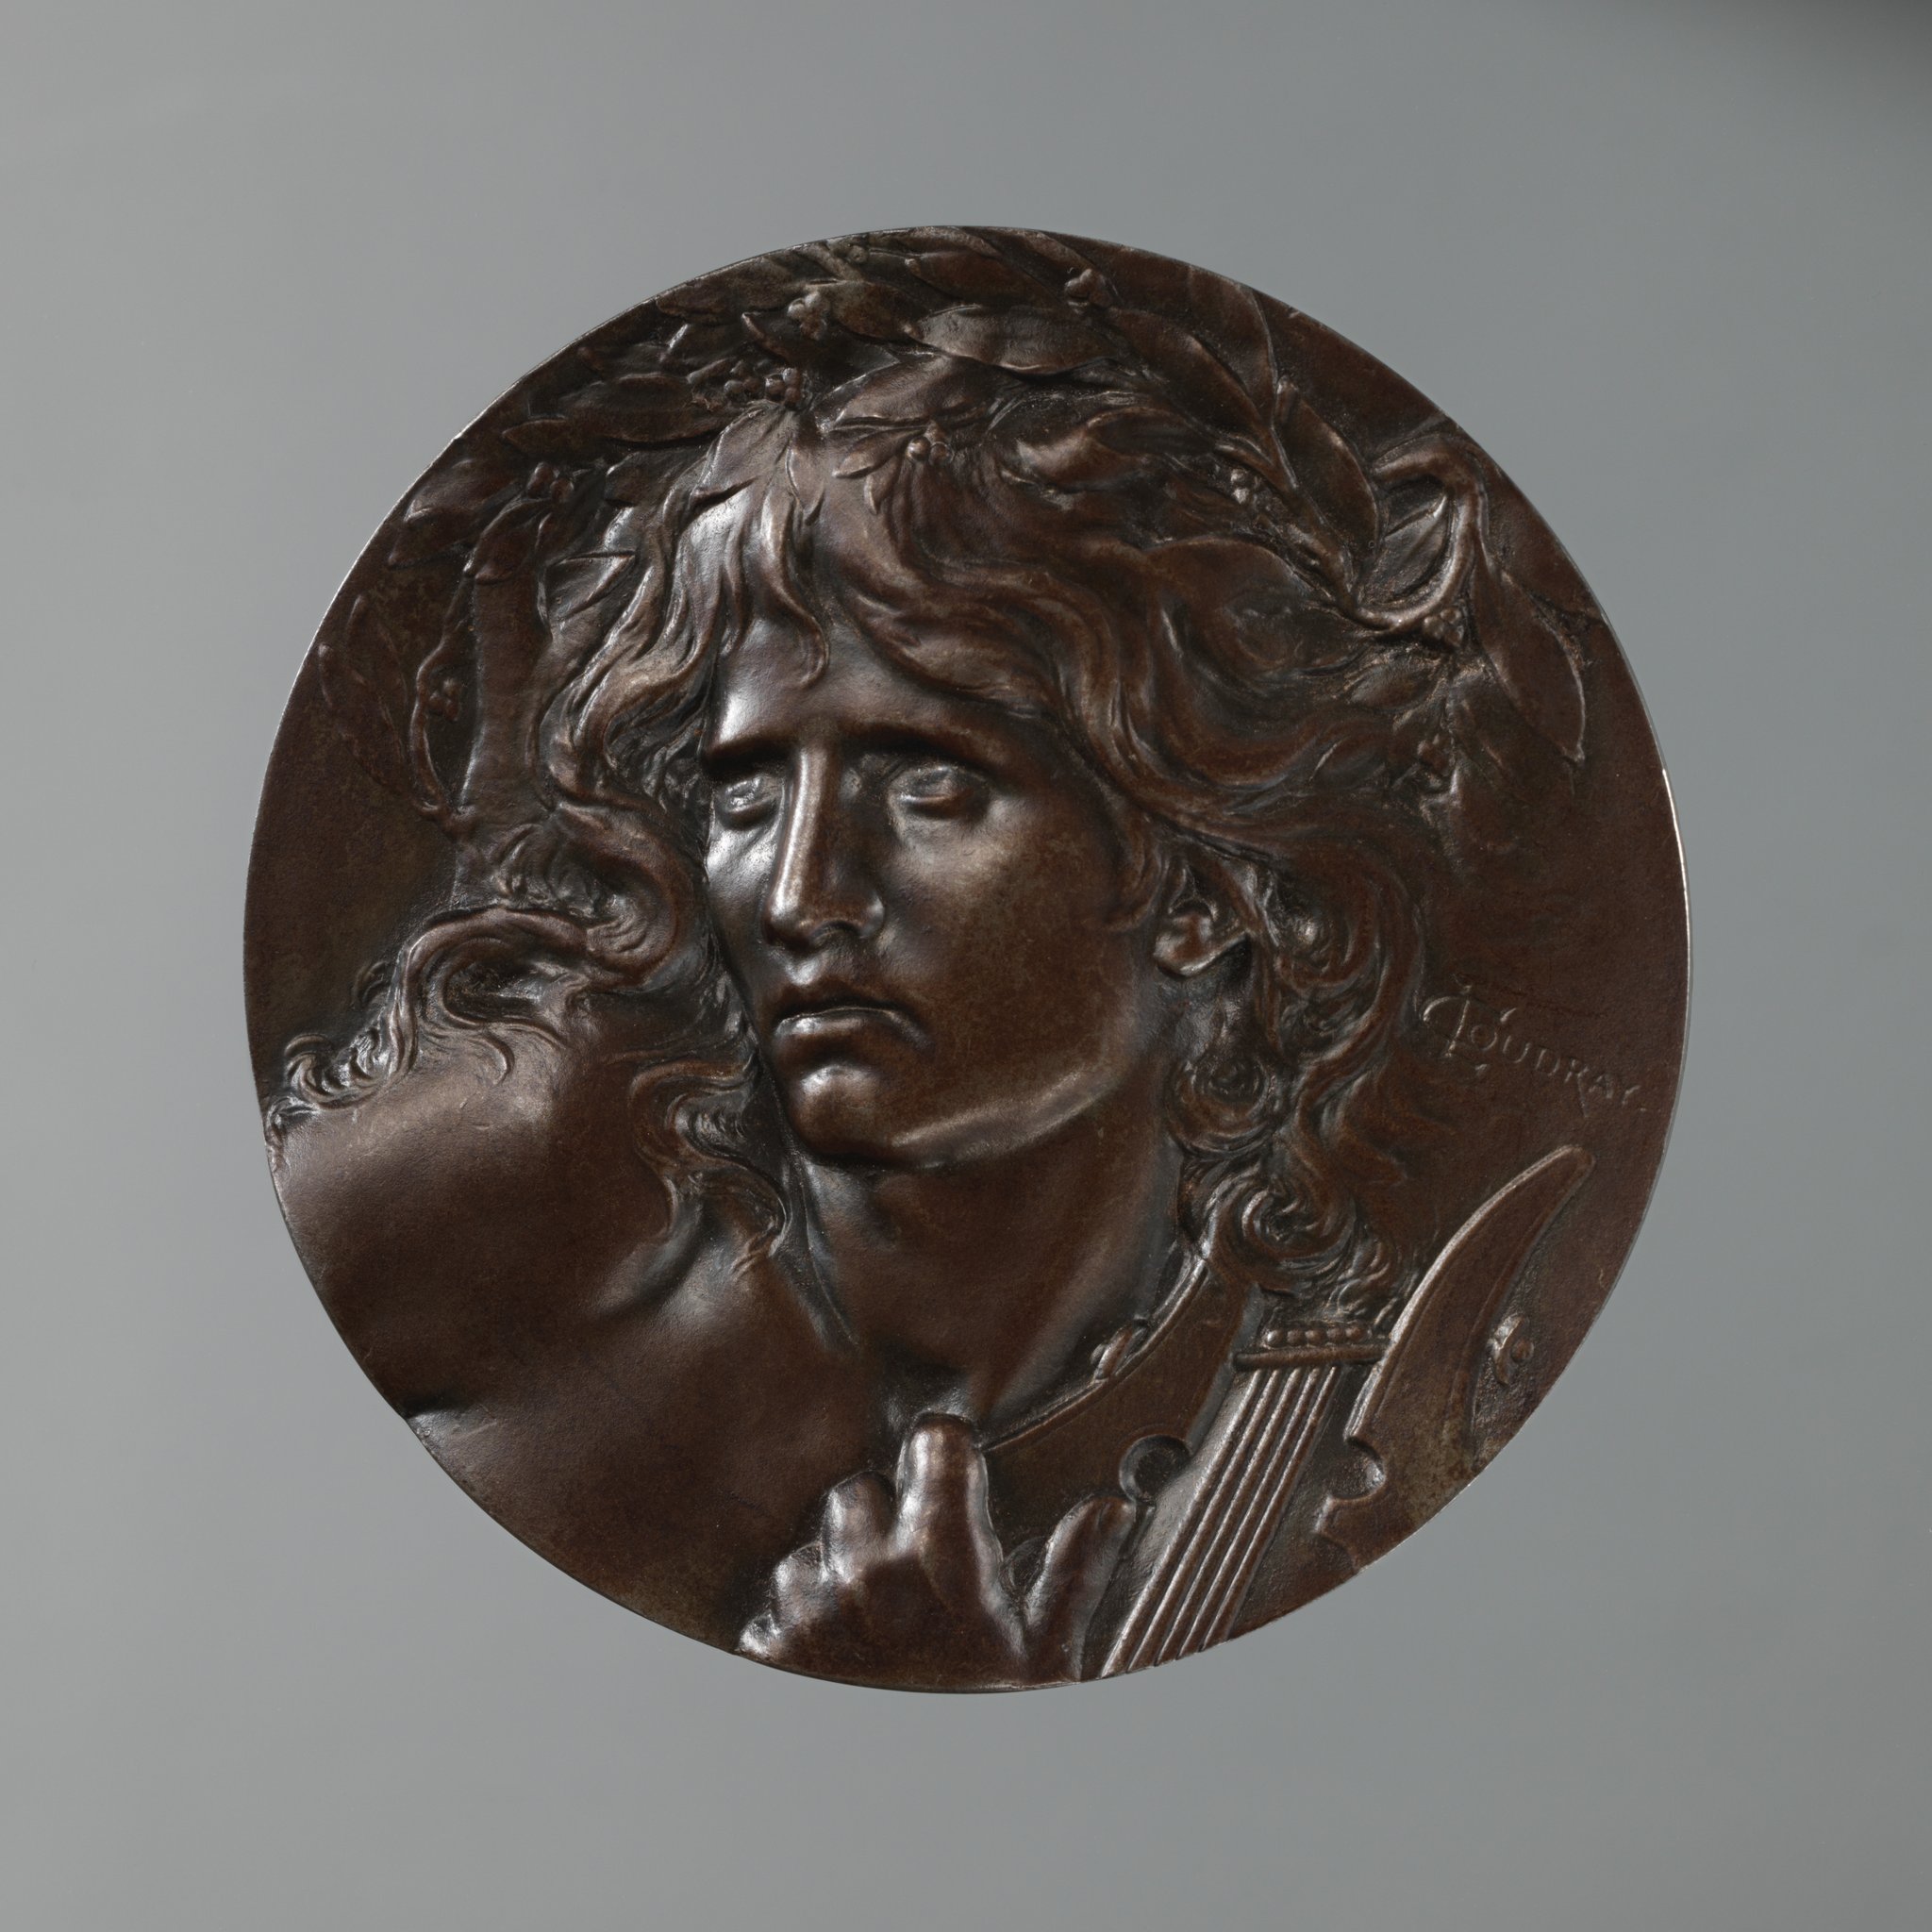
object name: medal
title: Orpheus, returning from Hades without Eurydice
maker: marie alexandre lucien coudray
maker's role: maker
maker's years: 1864-1964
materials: iron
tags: musical instruments,men,orpheus,lyres